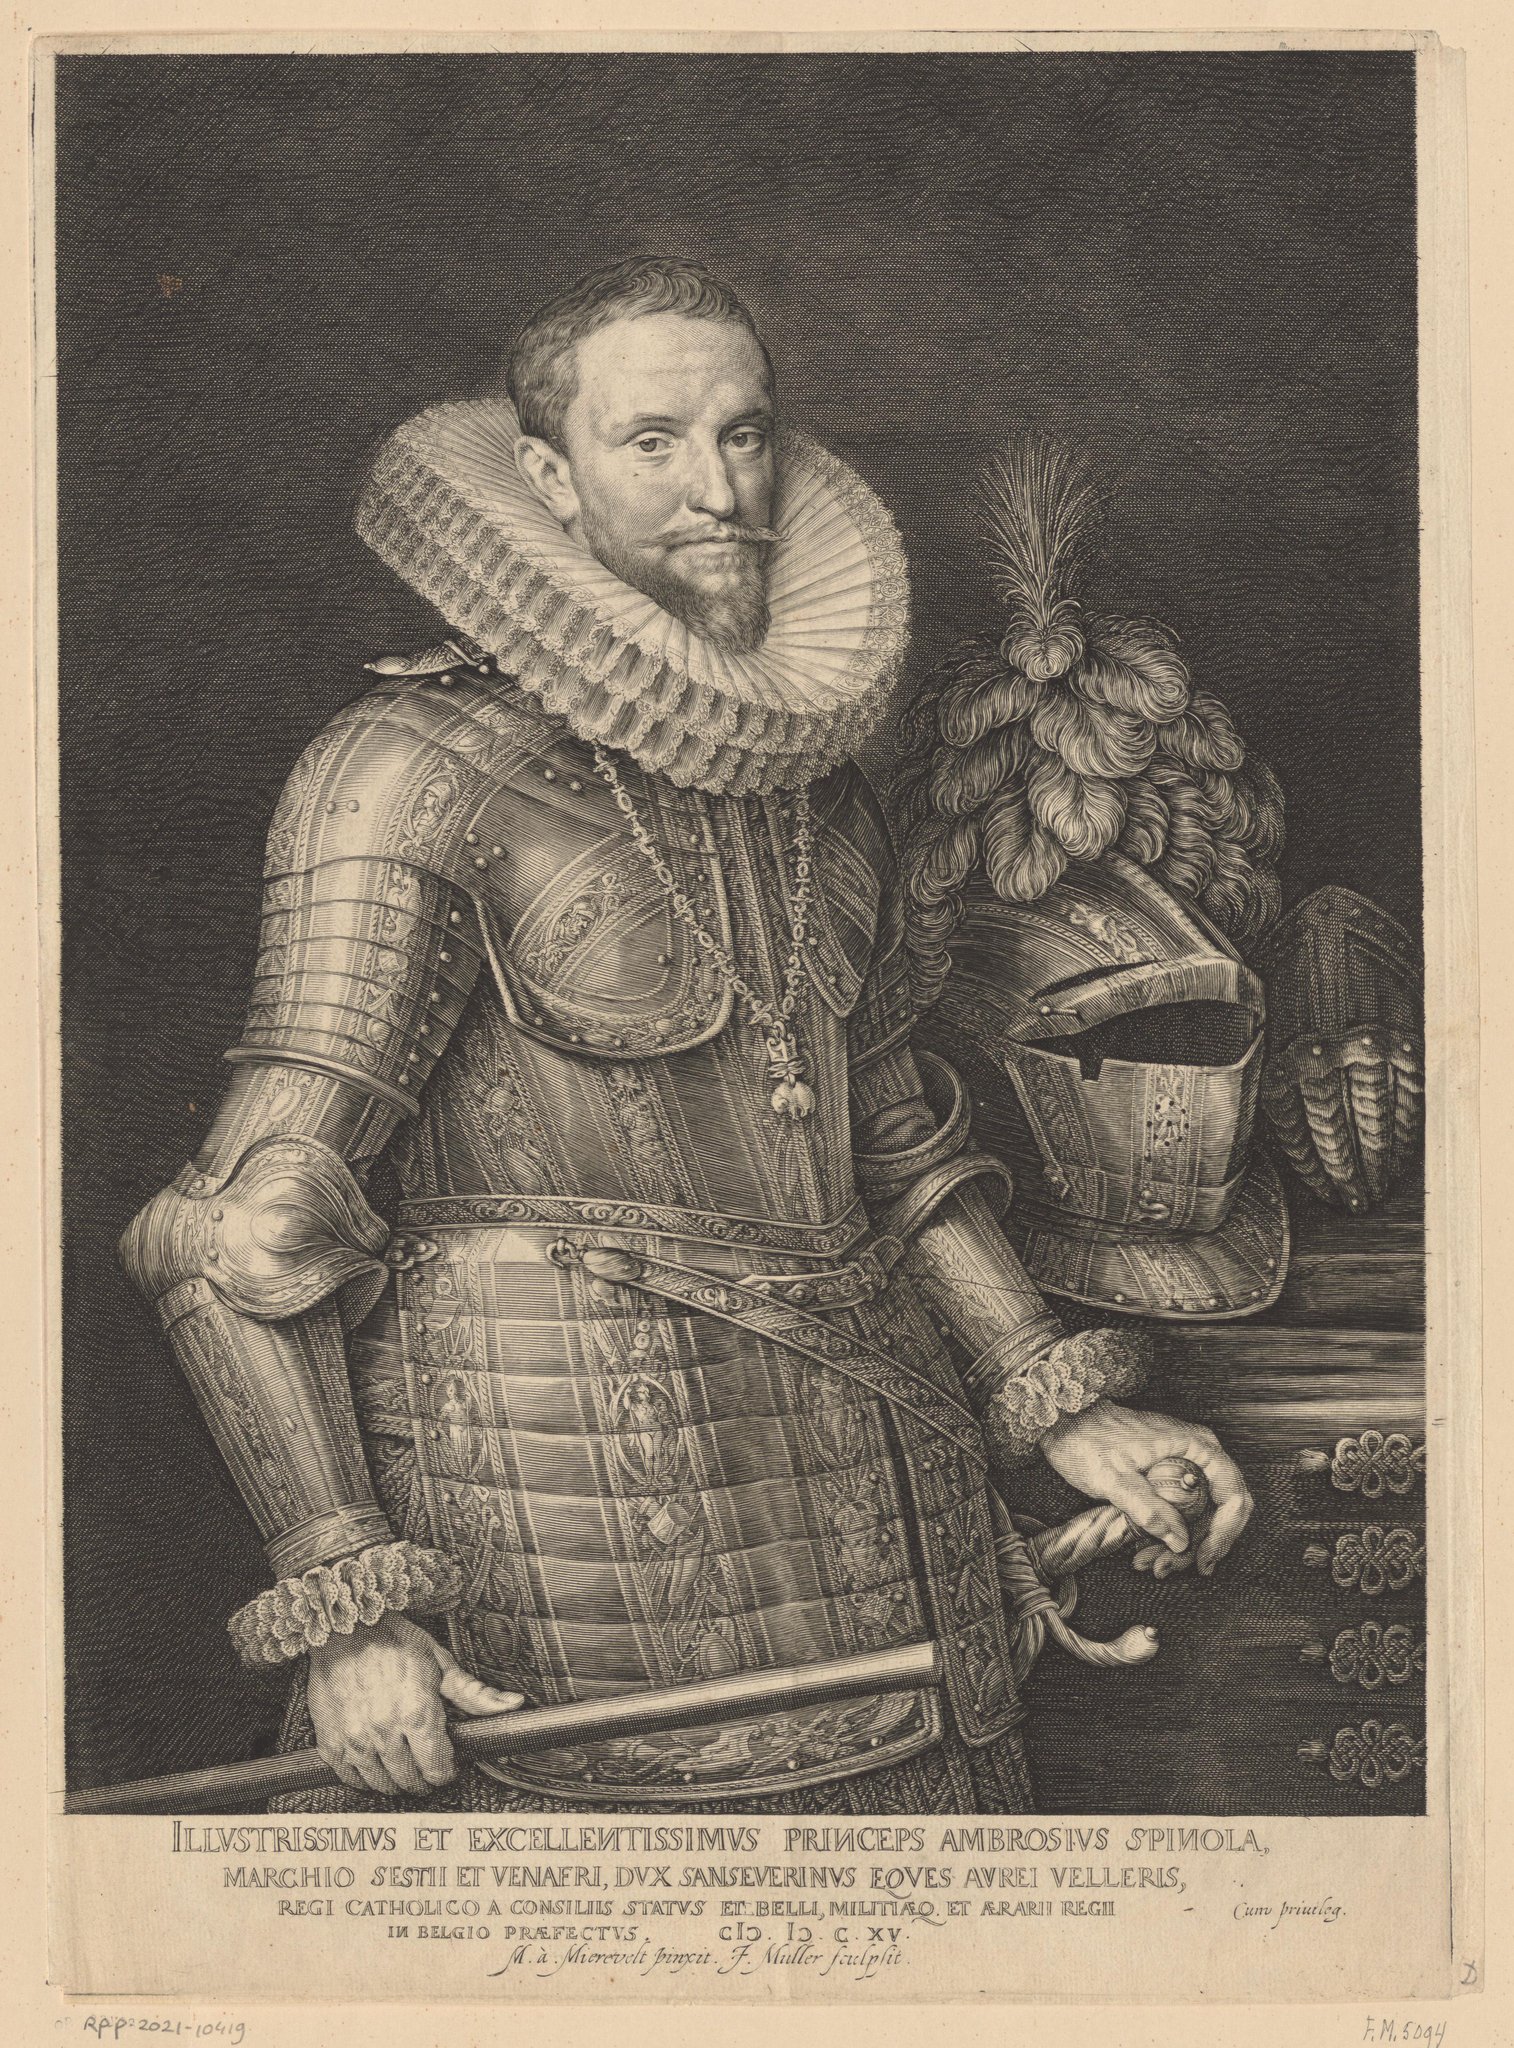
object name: print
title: Portret van Ambrogio Spinola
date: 1615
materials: paper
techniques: engraving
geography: amsterdam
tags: helmet, adult man, historical persons, knighthood order of the golden fleece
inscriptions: inscription: ‘KB’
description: Portret van Ambrogio Spinola, markies de los Balbases, gekleed in harnas met een bevelhebbersstaf in zijn hand. Rechts op tafel zijn helm.